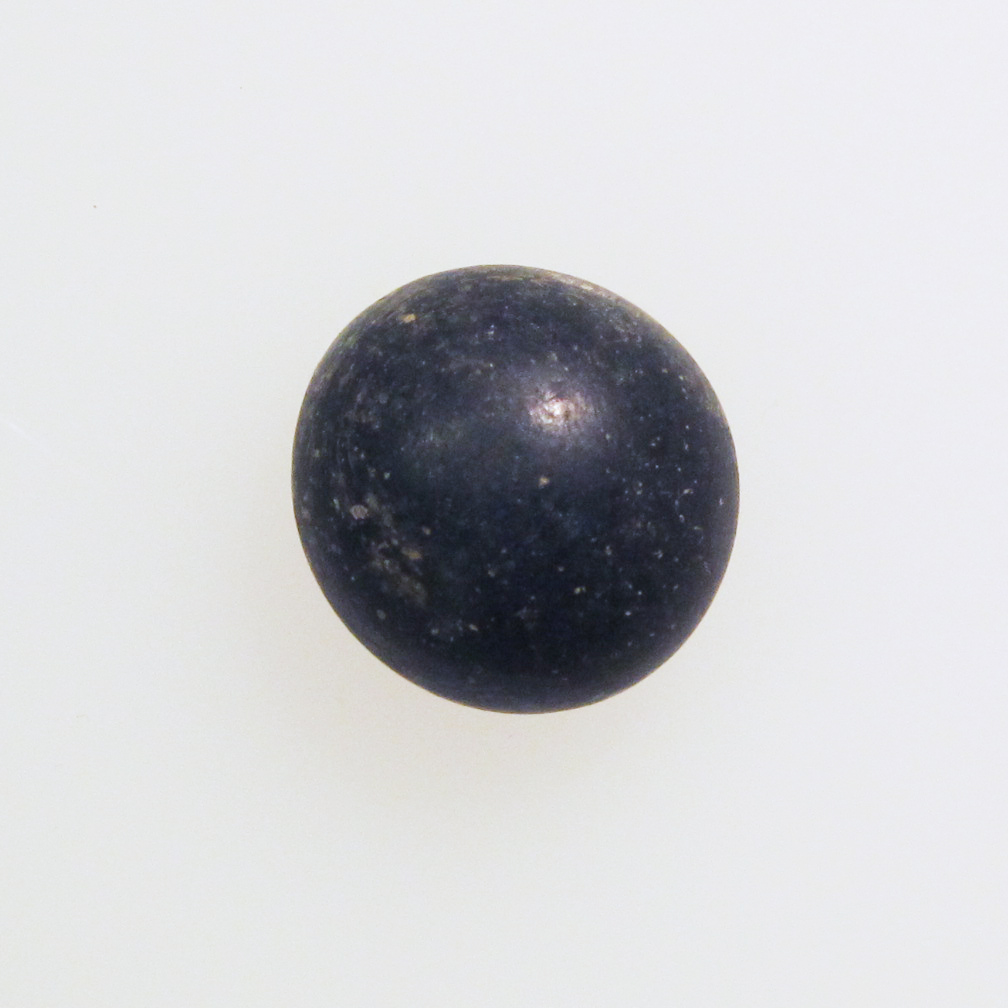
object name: pinhead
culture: roman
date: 100 BCE-500 CE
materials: glass